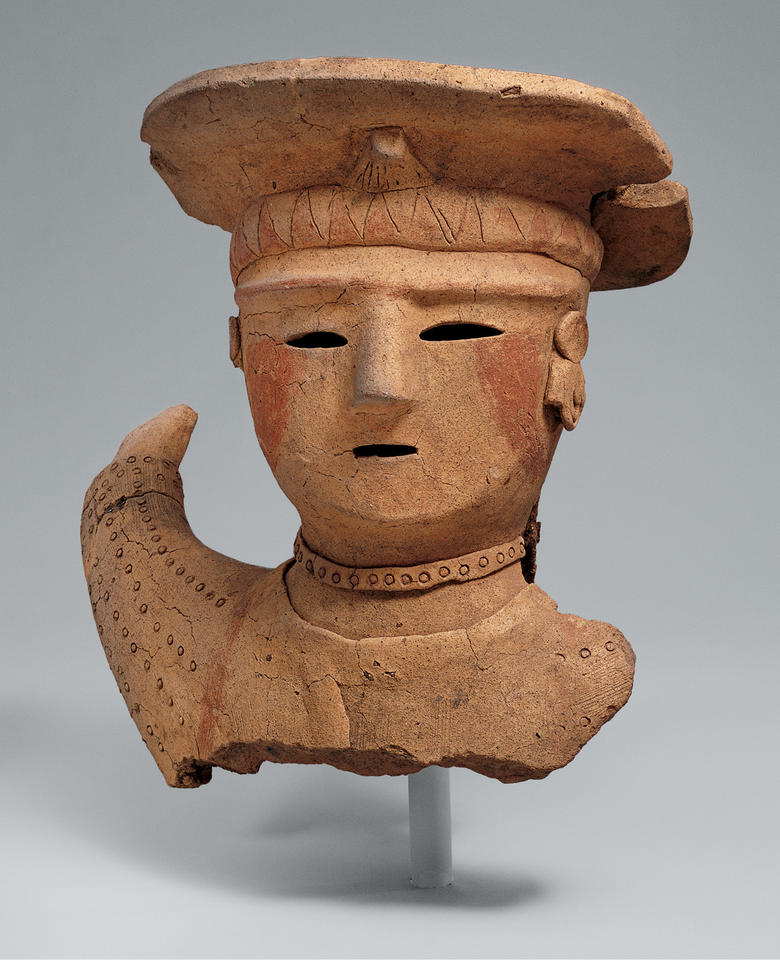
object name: haniwa figure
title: Haniwa (Clay Sculpture) of a Female Shrine Attendant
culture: japanese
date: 501-600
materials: earthenware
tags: women